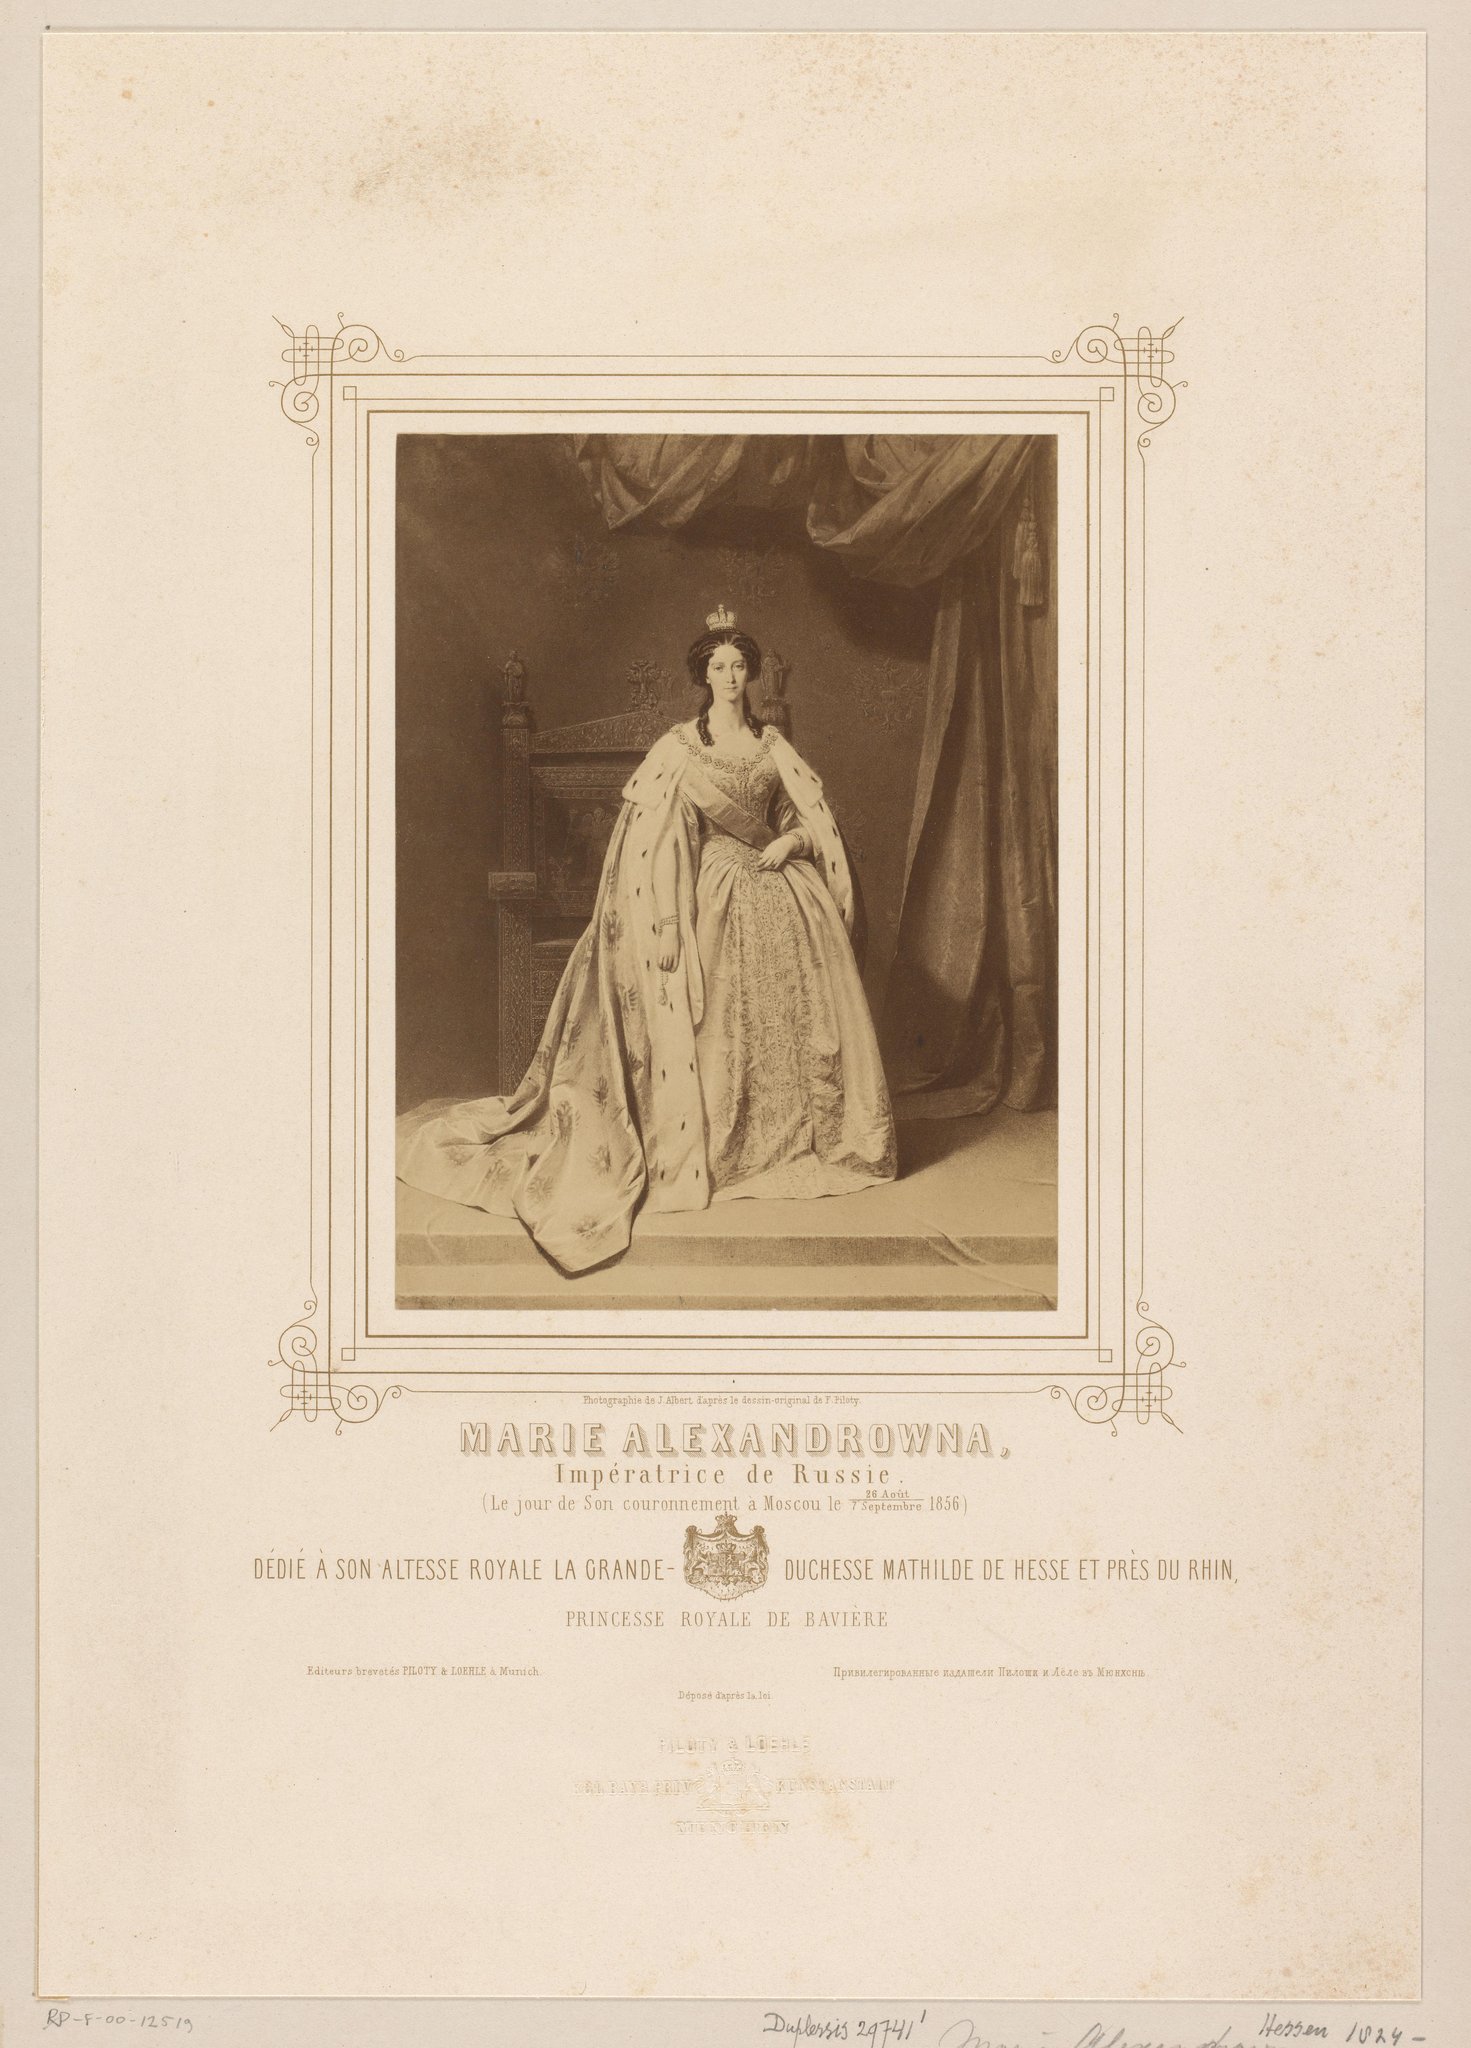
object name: reproduction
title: Fotoreproductie van een geschilderd portret van Marie Alexandrovna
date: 1860-1866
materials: cardboard, paper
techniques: albumen print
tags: historical persons - bb - woman